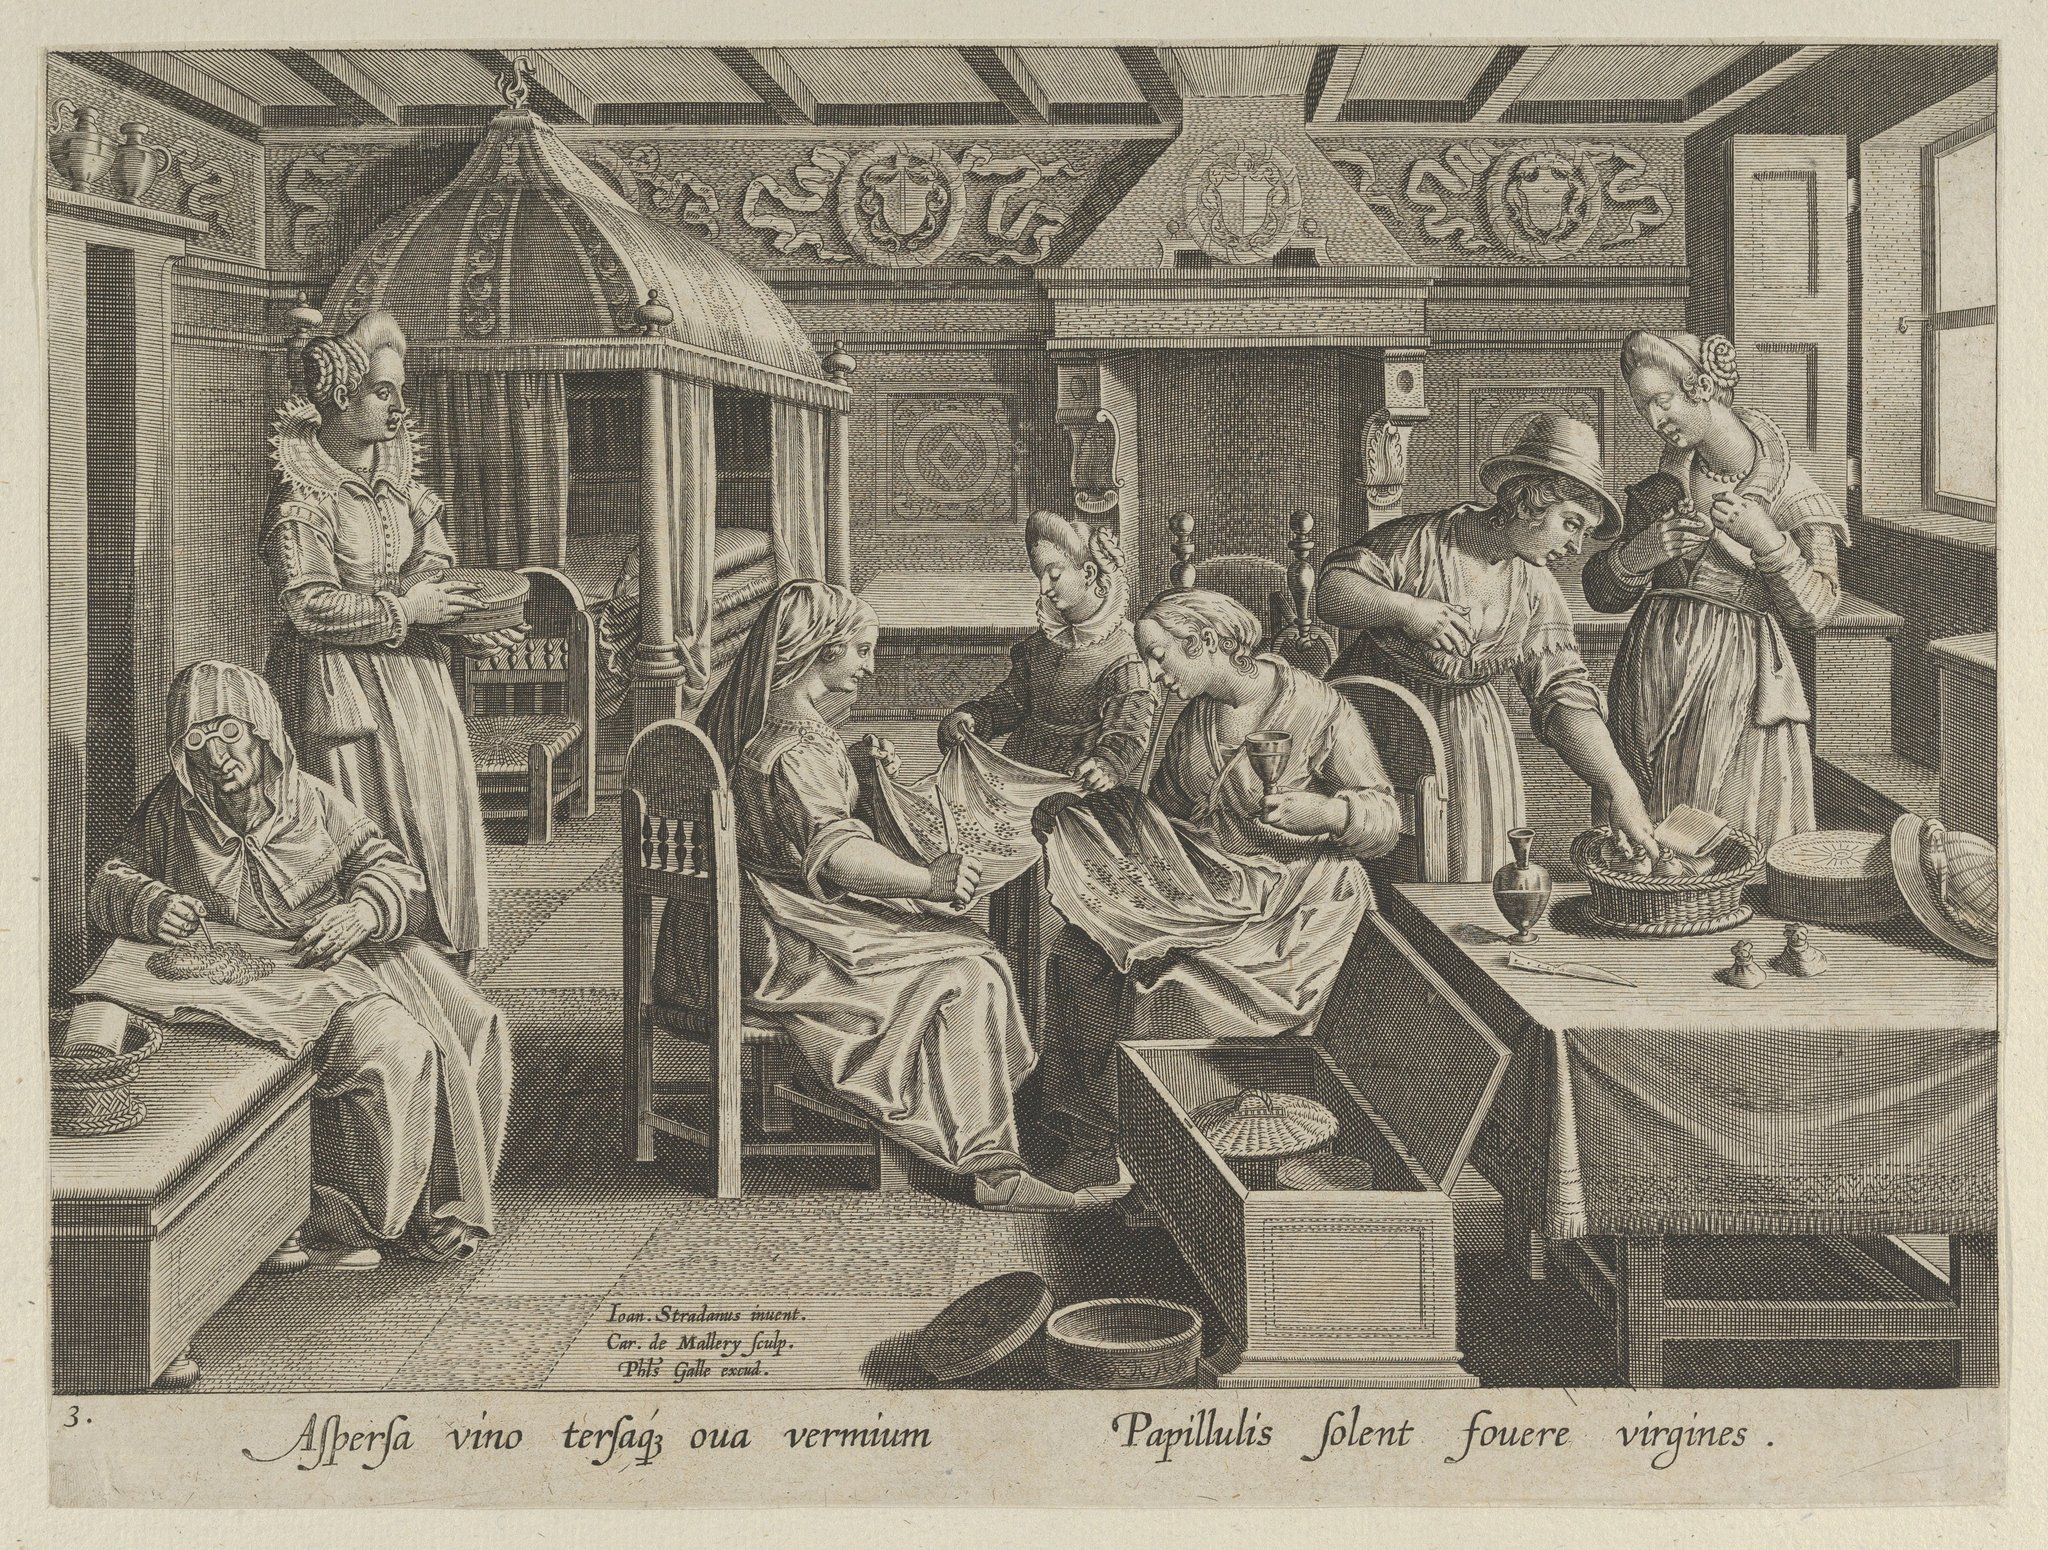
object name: print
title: The Incubation of the Silkworm Eggs, Plate 3 from "The Introduction of the Silkworm" [Vermis Sericus]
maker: karel van mallery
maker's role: artist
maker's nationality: netherlandish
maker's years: 1571-1645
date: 1595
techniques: engraving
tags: interiors,women